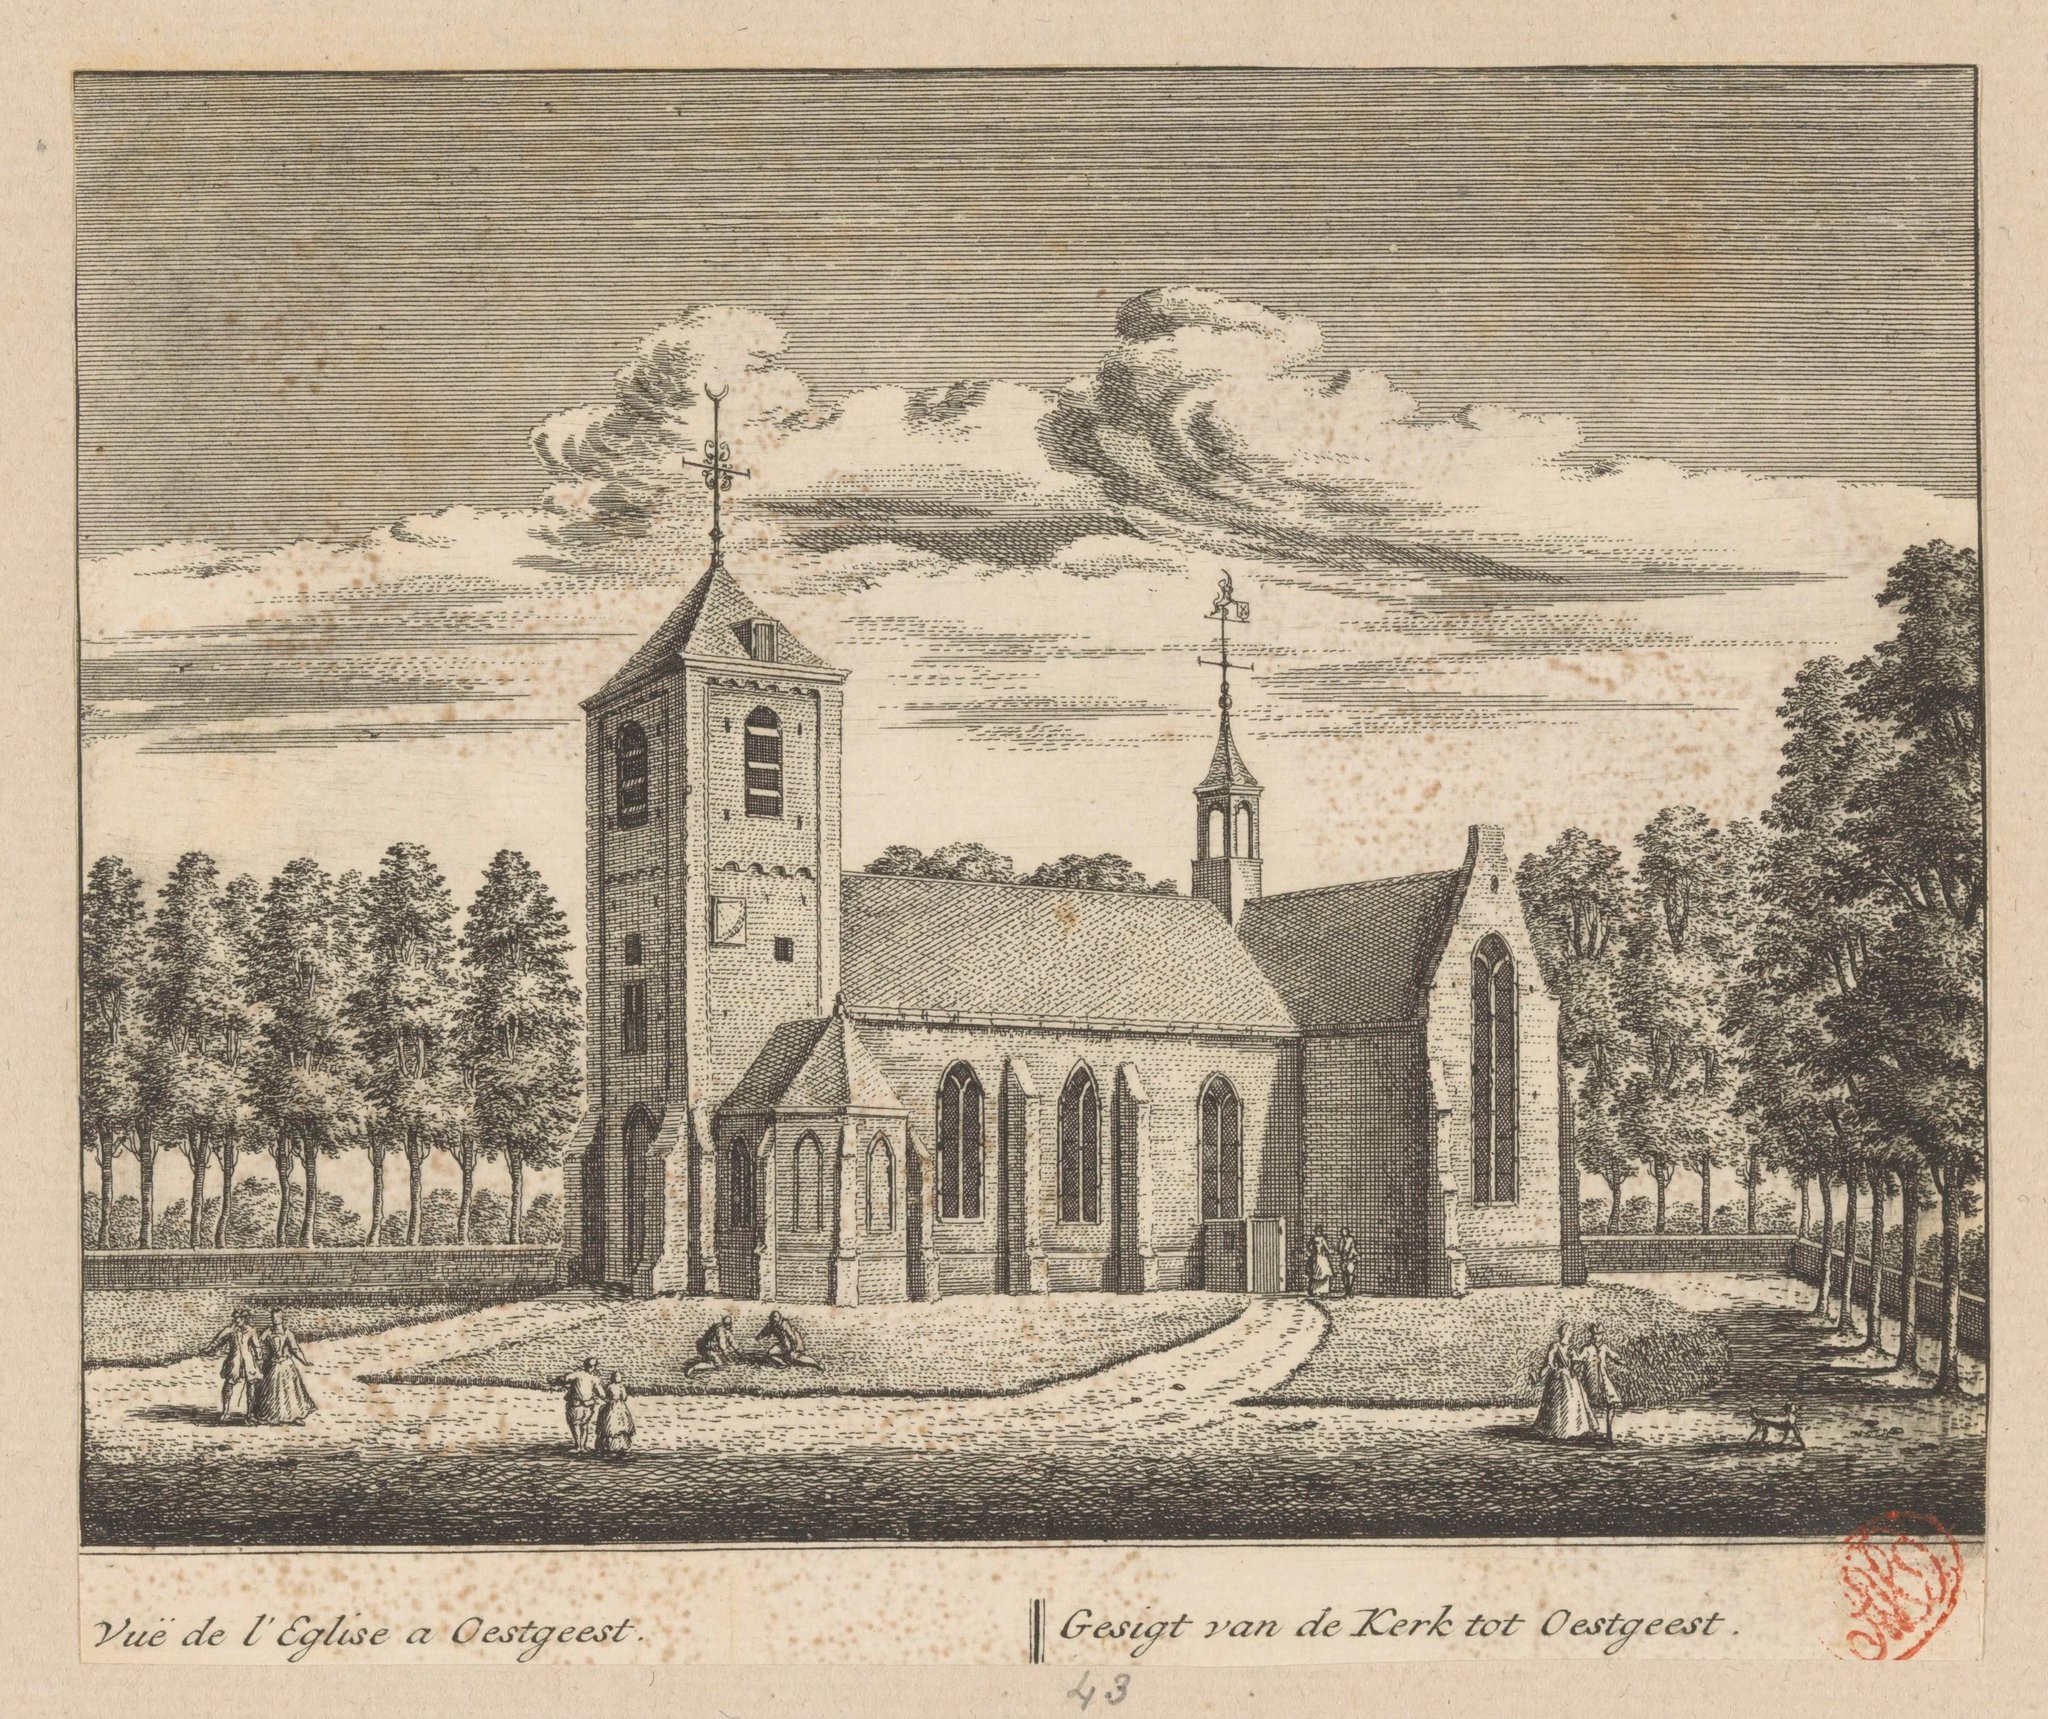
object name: book illustration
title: Gesigt van de kerk tot Oestgeest / Vuë de l'eglise a Oestgeest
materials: paper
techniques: etching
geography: amsterdam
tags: church (exterior)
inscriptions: collector's mark: Lugt 195, collector's mark: Lugt 2228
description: Prent ook gebruikt in: Rademaker, Abraham. Rhynlands fraaiste gezichten; vertonende alle deszelfs lustplaatzen, heeren-huizen en dorpen. Van halfwegen Haarlem en Leyden (…) / Les plus agréables vuës de Rhynland, representant toutes les maisons de plaisance, maisons seigneuriales & villages. Commençant à demilieu Haarlem & Leyden (…). Ansterdam: Leonard Schenk, 1732.